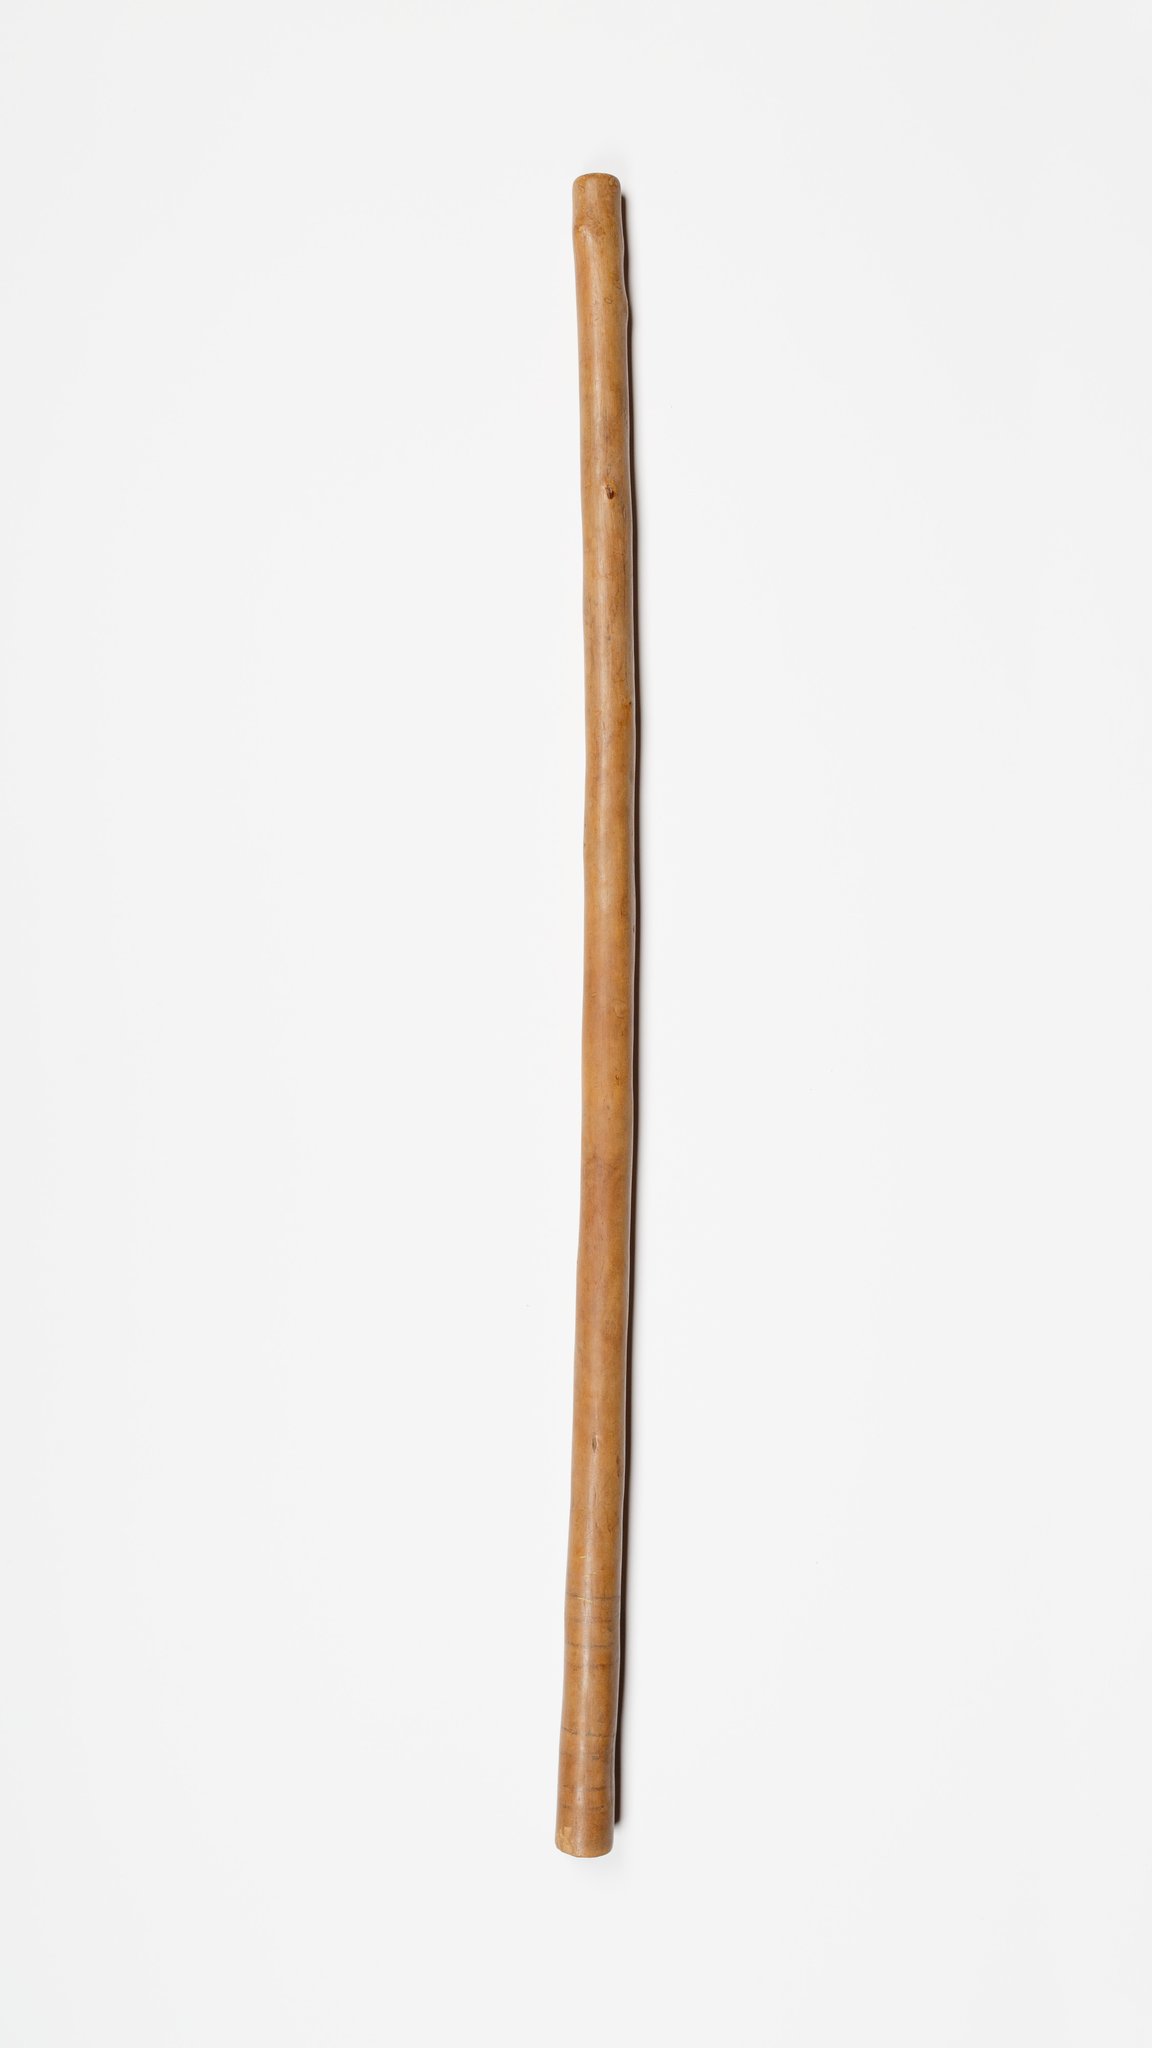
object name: ax handle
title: Handle of an ax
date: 1981-1550 BCE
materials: wood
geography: middle egypt